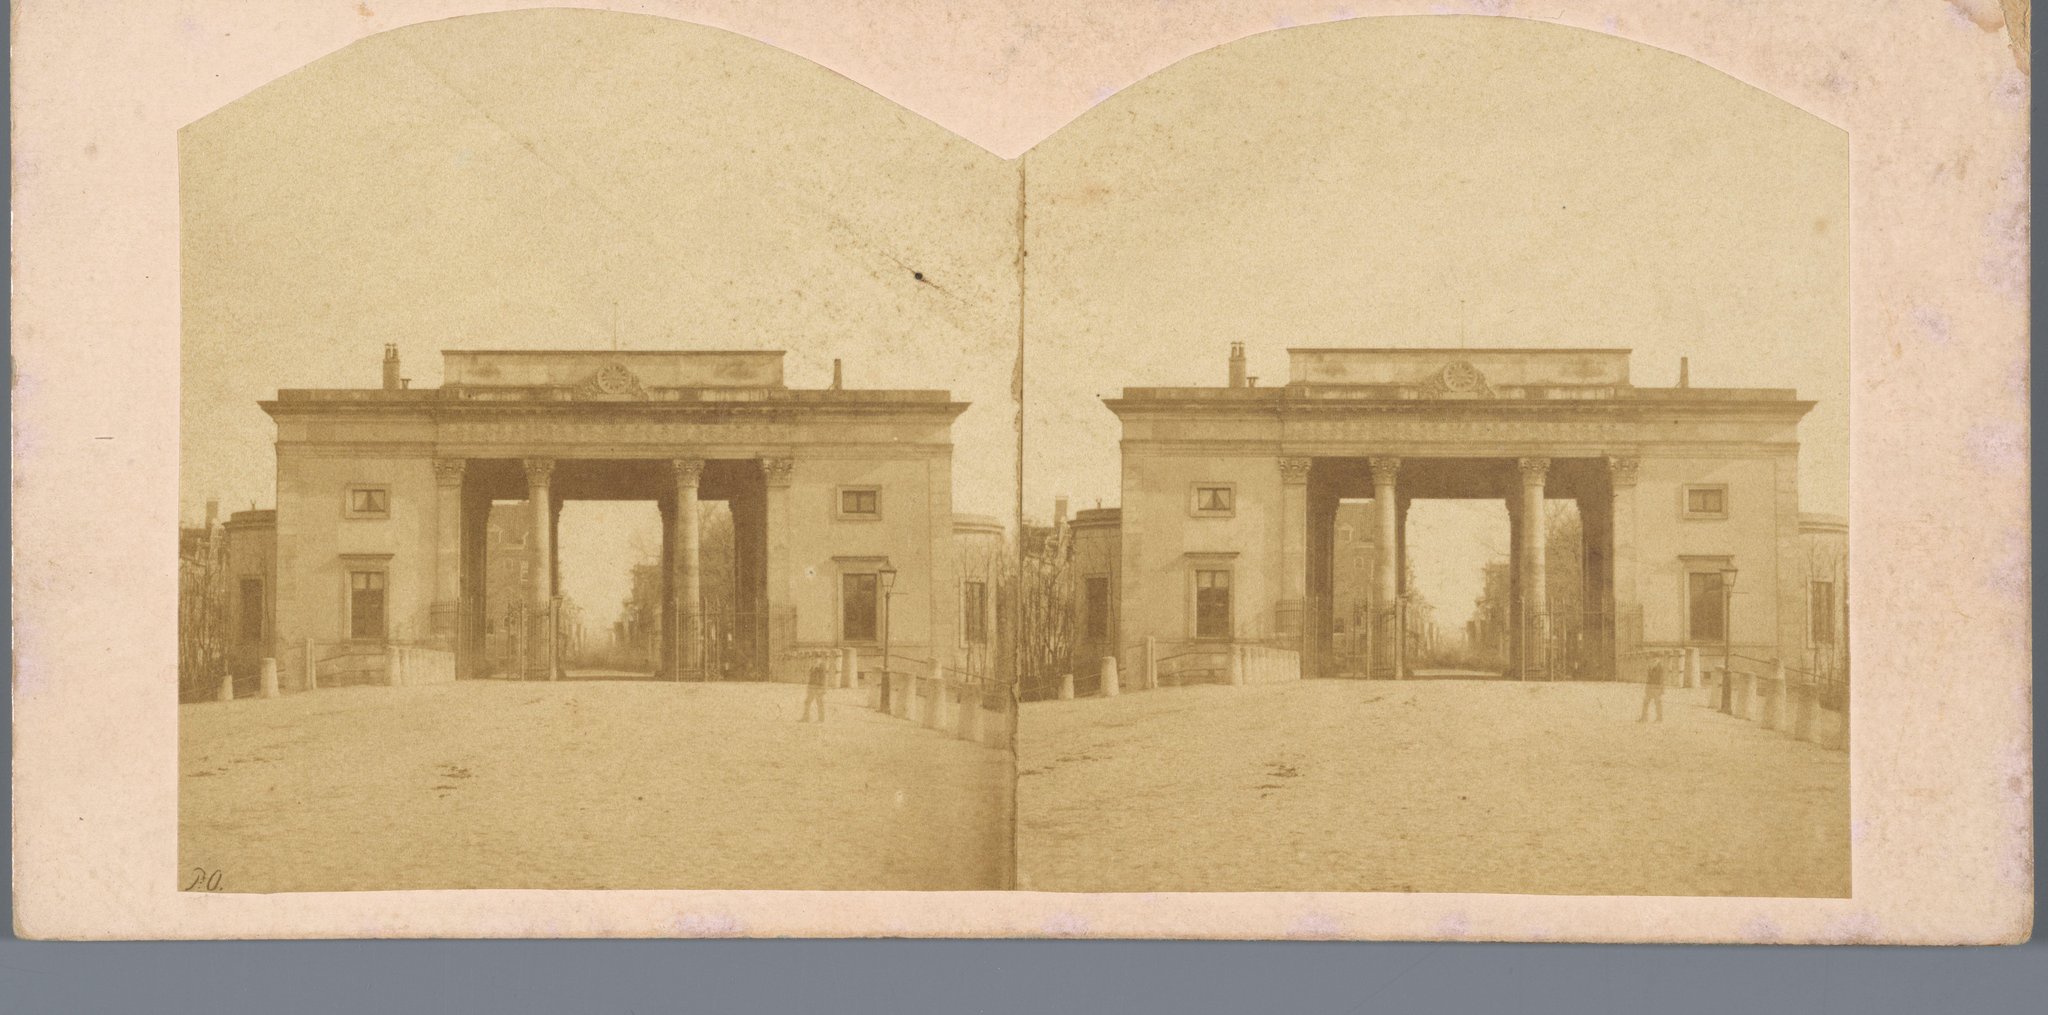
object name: photograph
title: De Nieuwe Haarlemmer- of Willemspoort te Amsterdam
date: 1857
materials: cardboard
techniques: albumen print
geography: amsterdam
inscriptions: signature